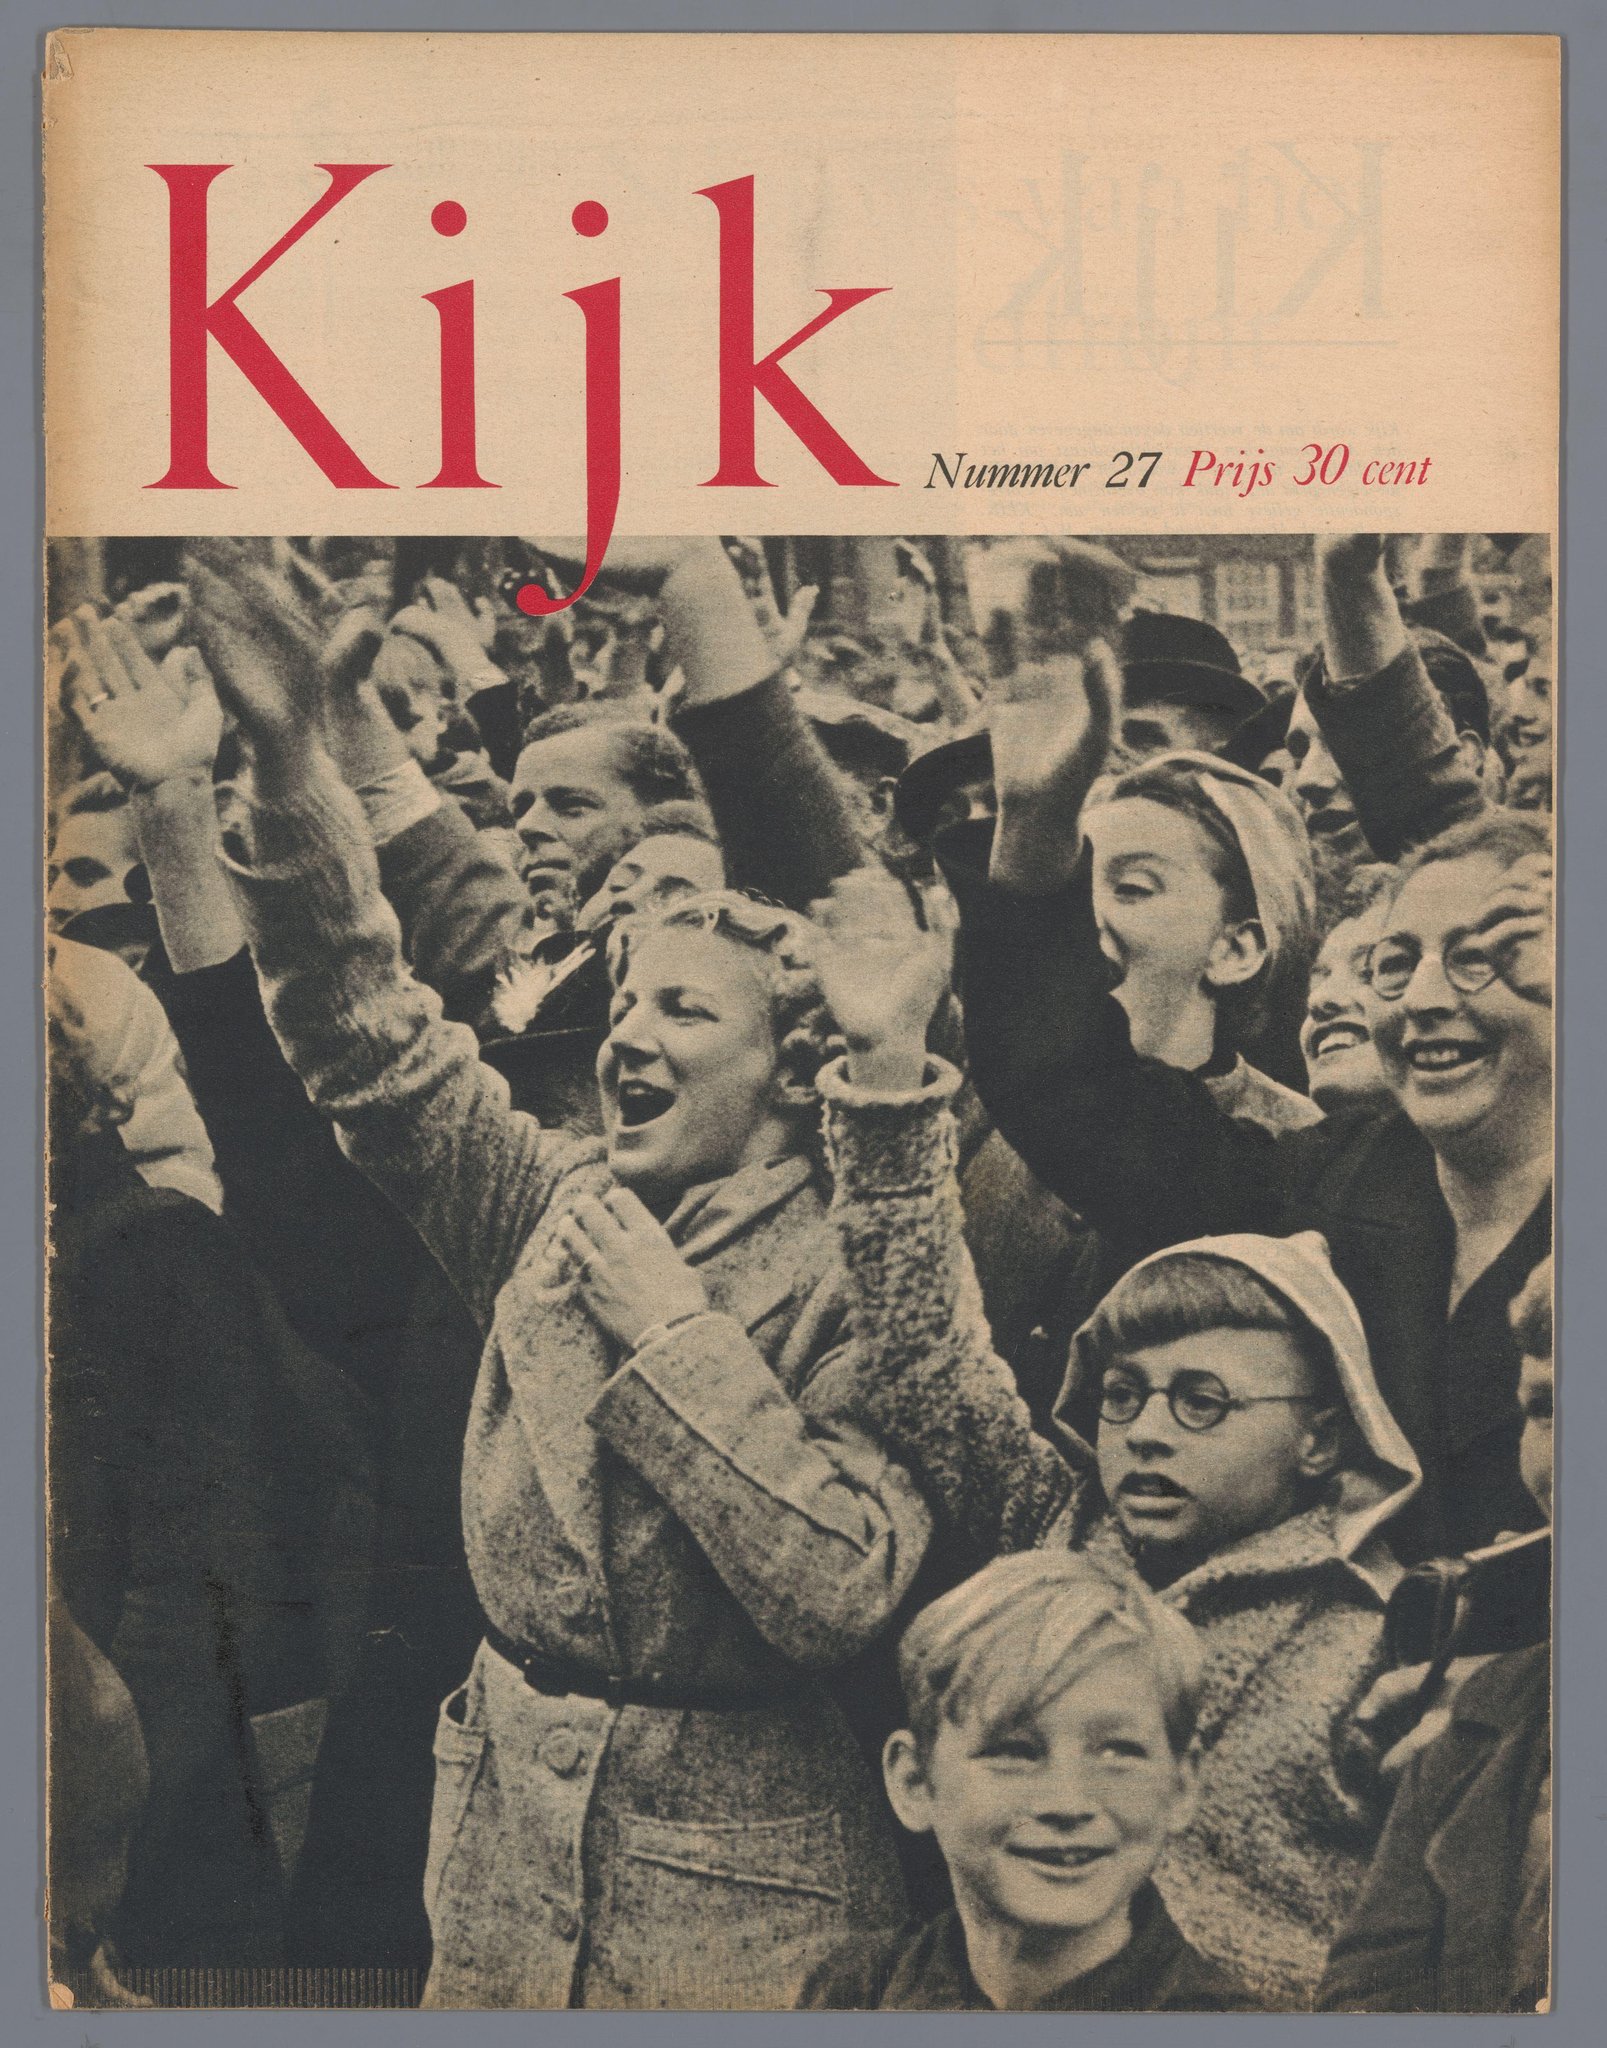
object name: magazine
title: 'Kijk', exemplaar nr. 27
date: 1945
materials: paper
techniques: printing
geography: london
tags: tweede wereldoorlog, bevrijding van nederland (1945)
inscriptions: title: ‘Kijk’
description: "Kijk wordt om de veertien dagen uitgegeven door de Amerikaanschen Voorlichingsdienst om eht wereldnieuws te geven in woord en beeld, totdat uw eigen pers deze taak kan overnemen." Omschrijving van het blad Kijk, overgenomen uit dit blad.